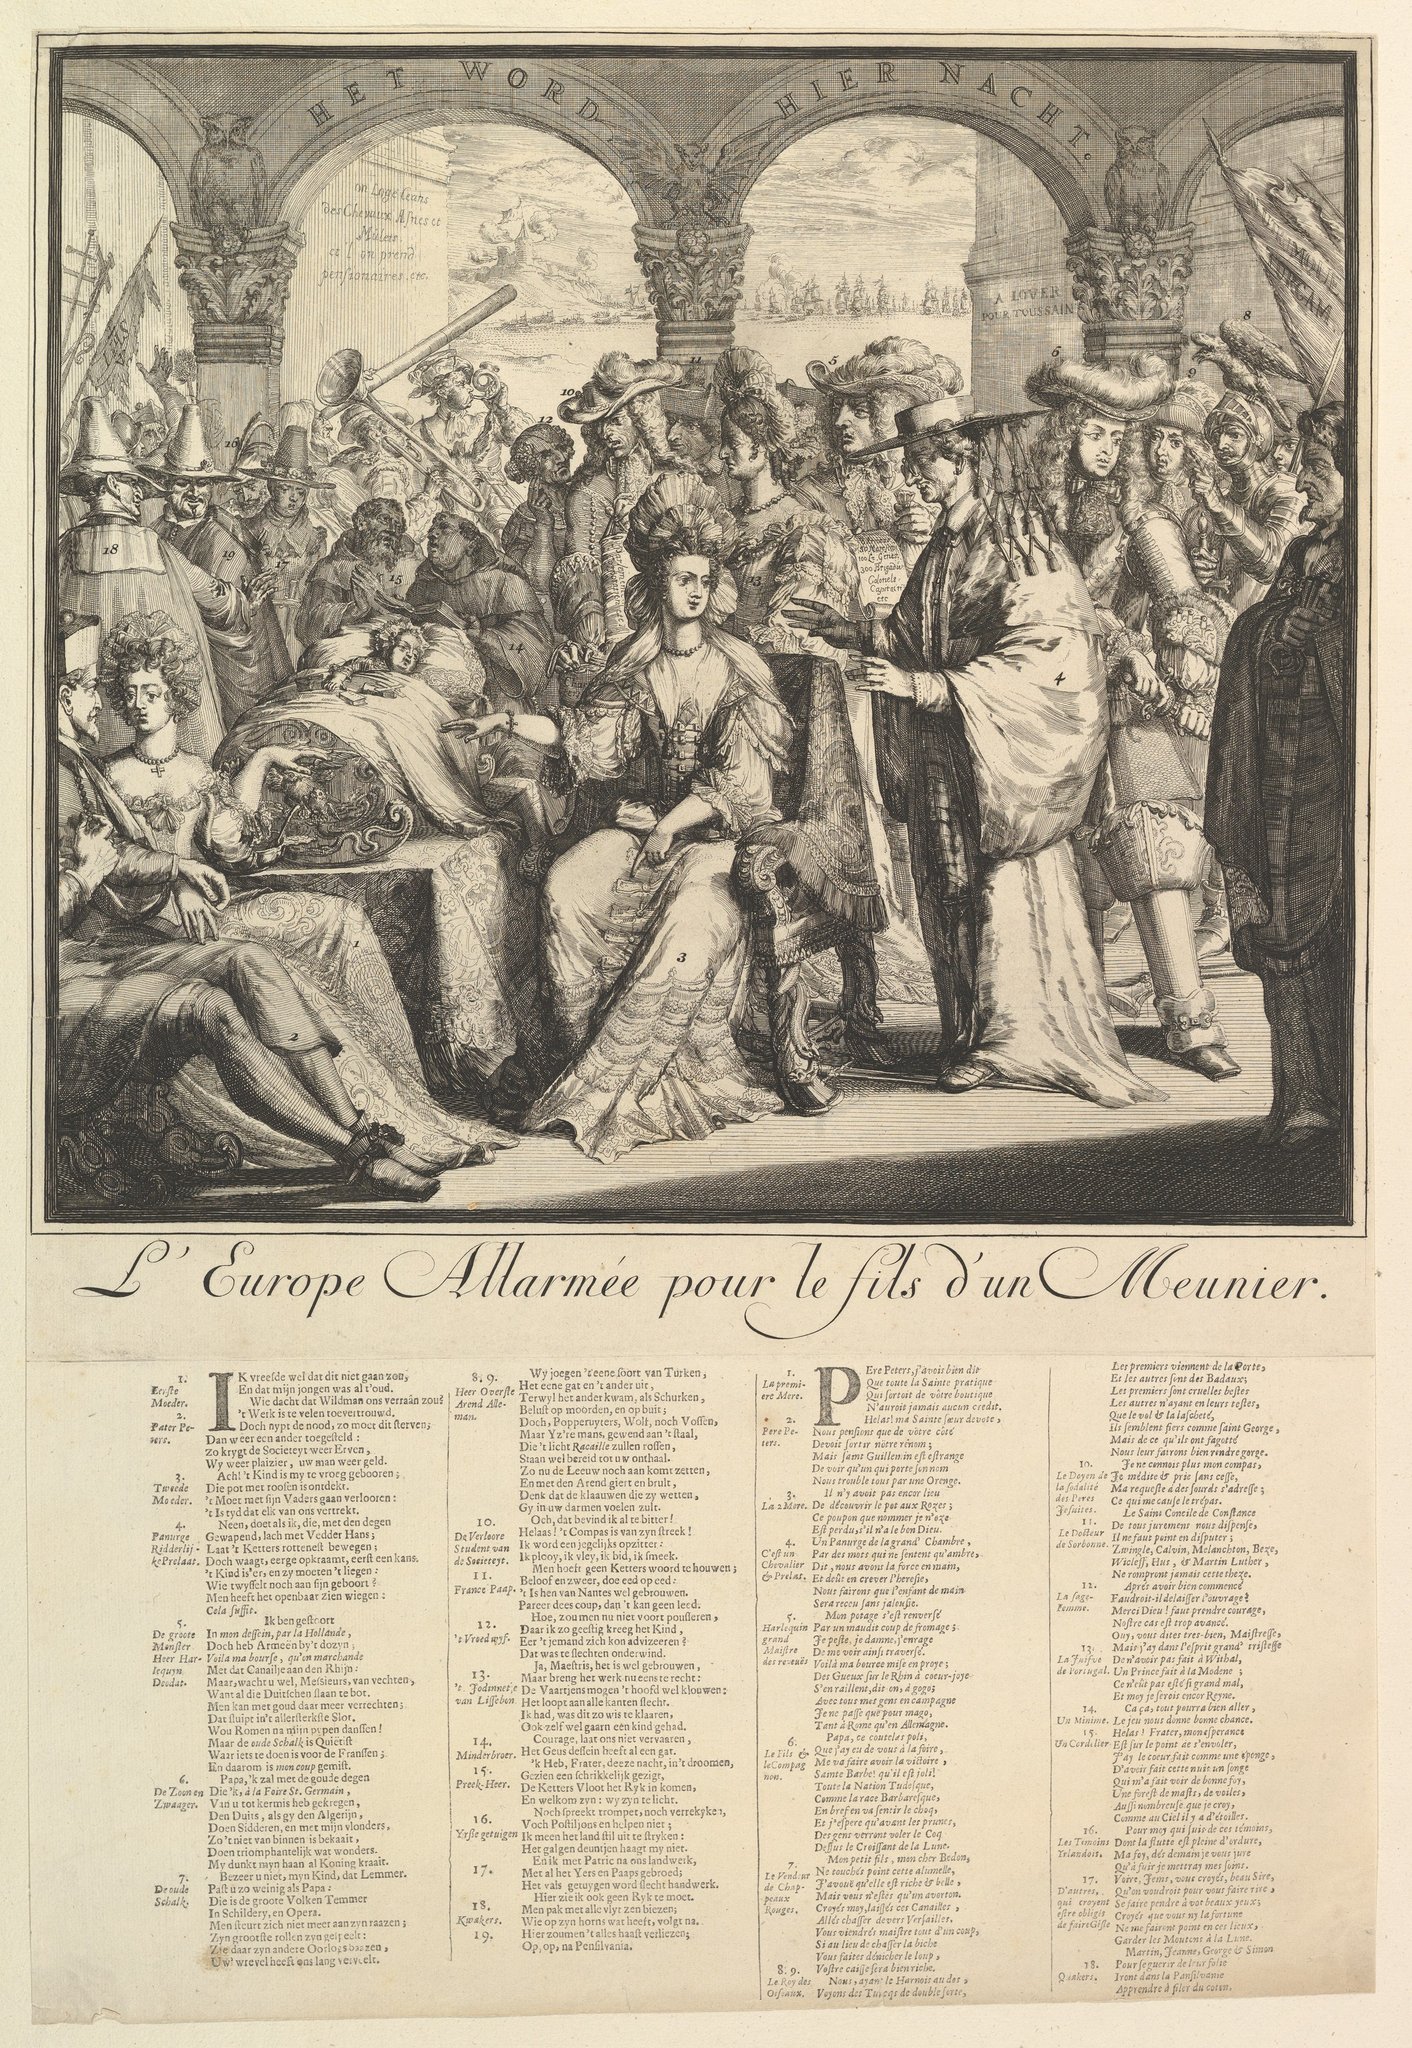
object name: print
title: L'Europe Allarmée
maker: romeyn de hooghe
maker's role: artist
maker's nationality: dutch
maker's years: 1645-1708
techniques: etching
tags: infants,men,women,owls,musicians